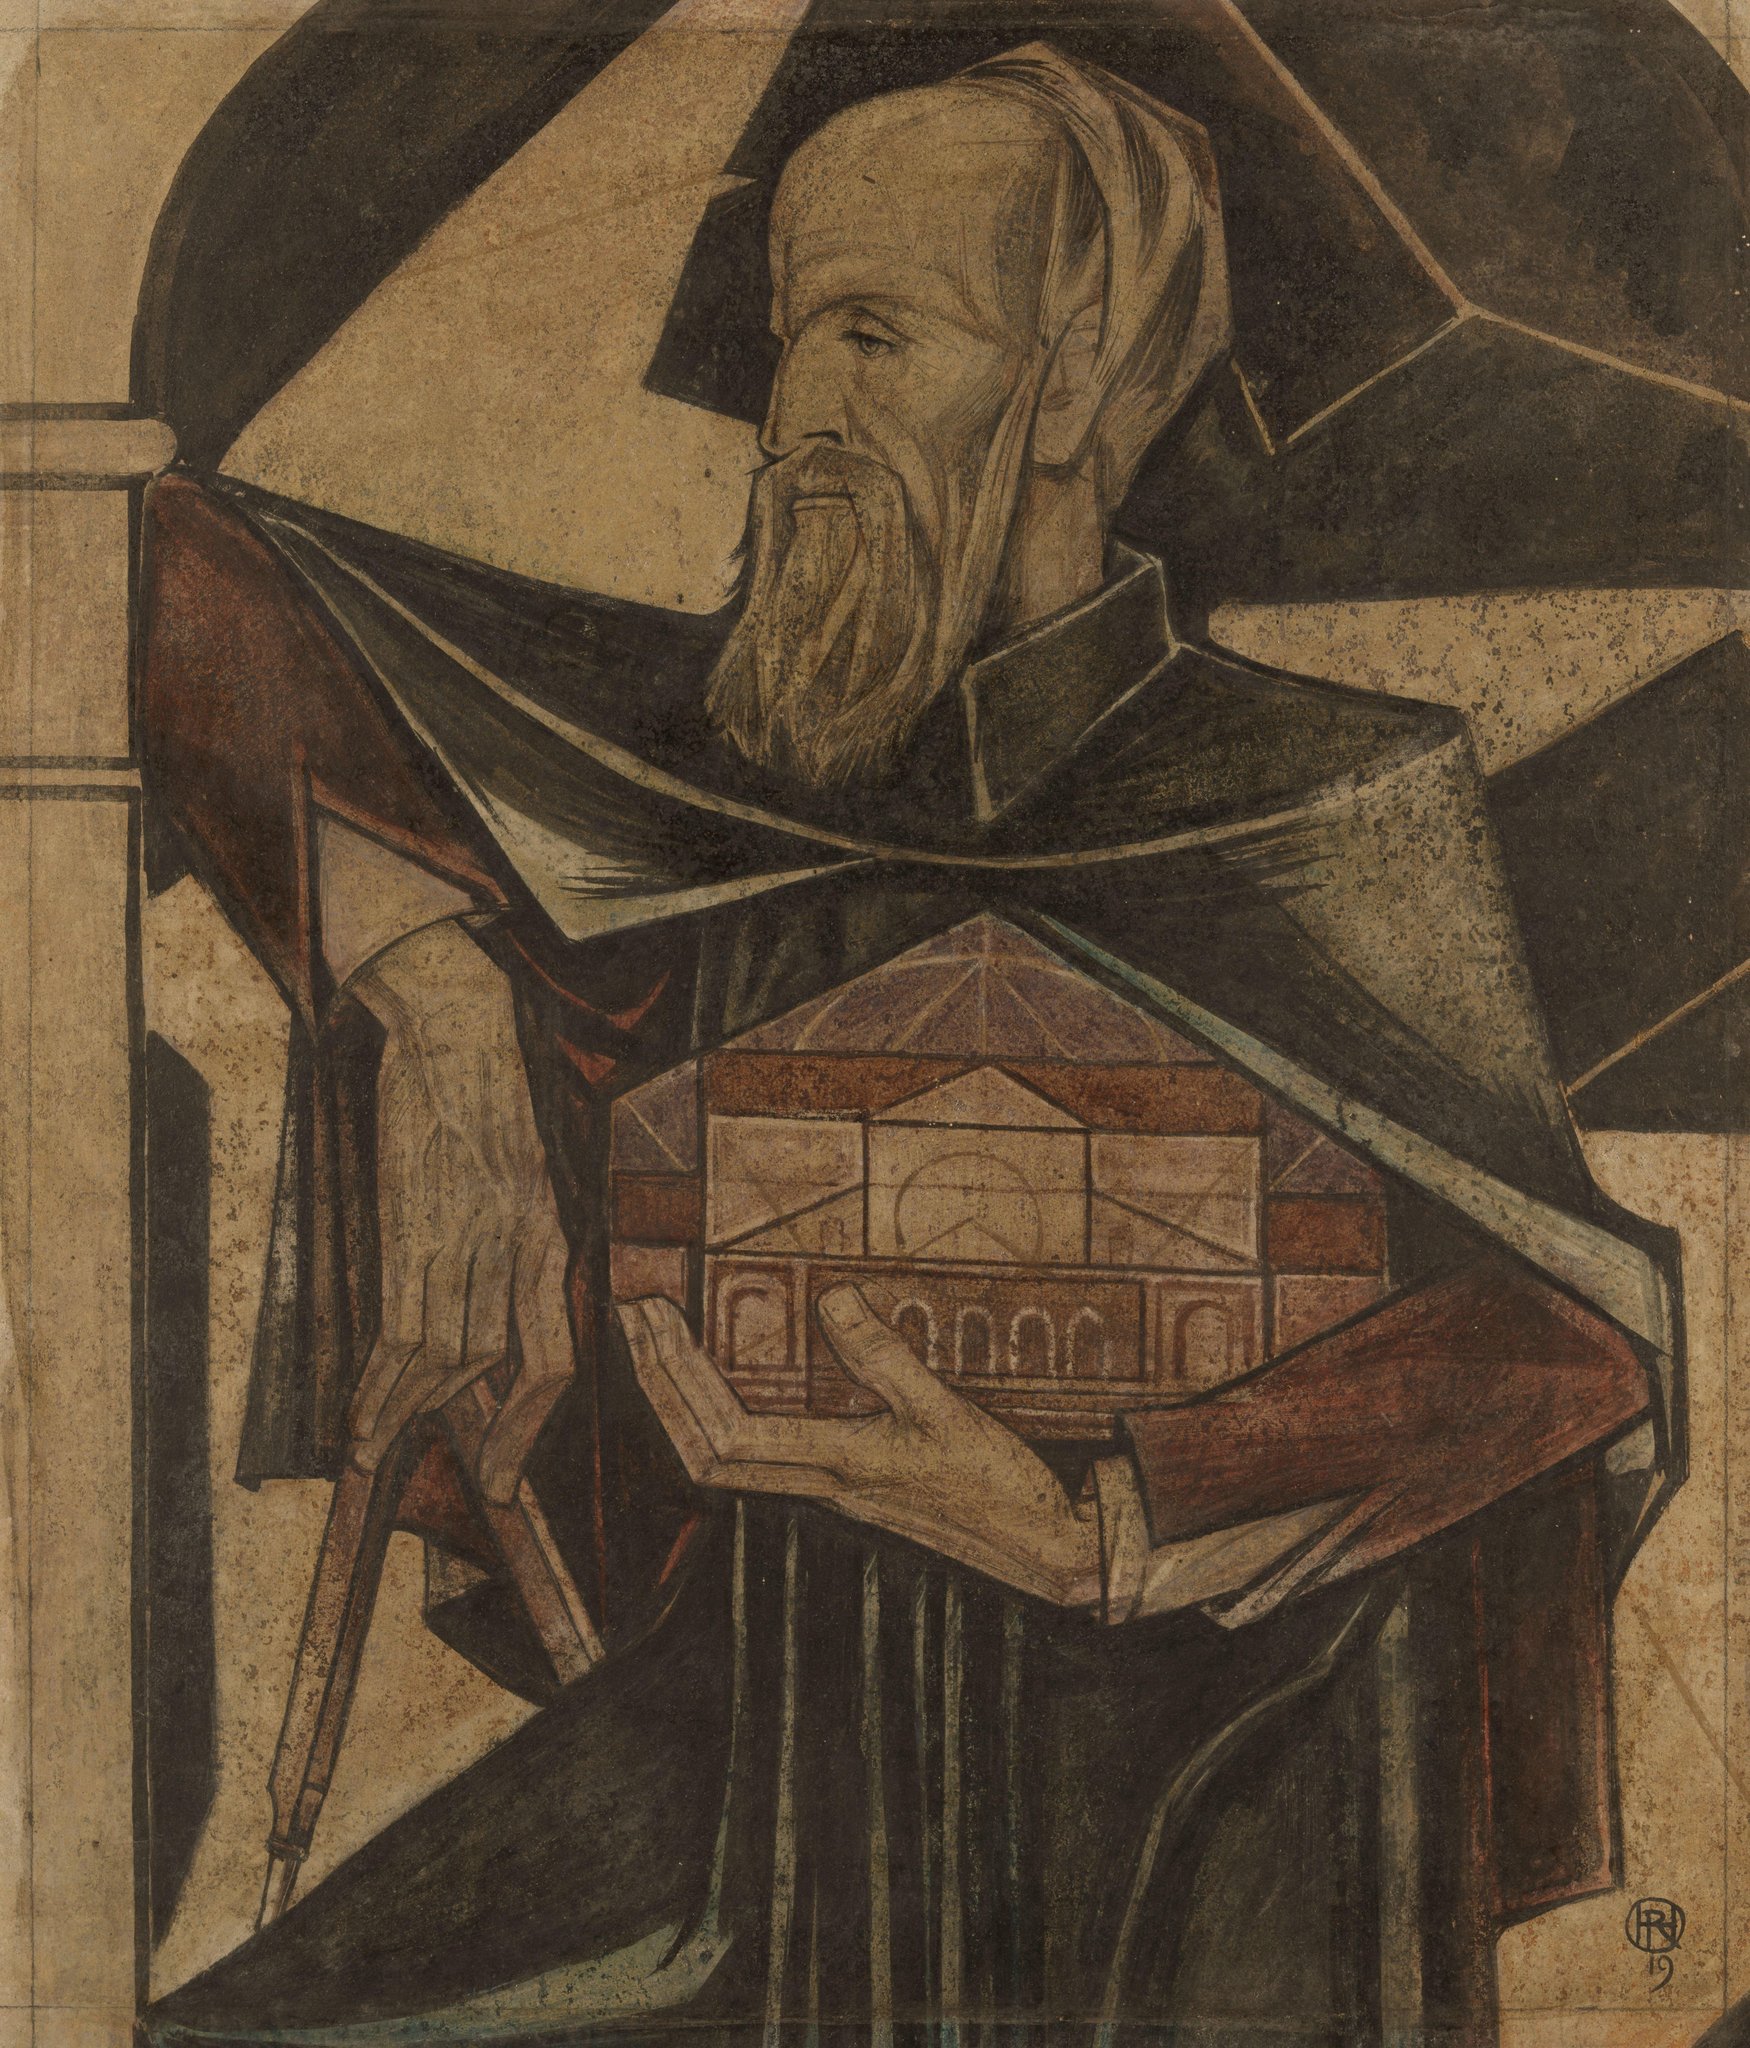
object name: painting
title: The Architect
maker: richard nicolaüs roland holst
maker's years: 1868-1938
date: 1919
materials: asbestos, asbestos cement, paint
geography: netherlands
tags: 'architectura', symbolic representations, allegories and emblems ~ architecture; 'architettura' (ripa)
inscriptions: signature and date: ‘[monogram] 19’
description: De bouwmeester. Een staande man, ten halven lijve, in de rechterhand een passer, in de linkerhand een schaalmodel van een gebouw. Soms geïnterpreteerd als Iram, de architect van de tempel van Salomo. Schets voor het schilderij in het Gemeentemuseum van Den Haag.